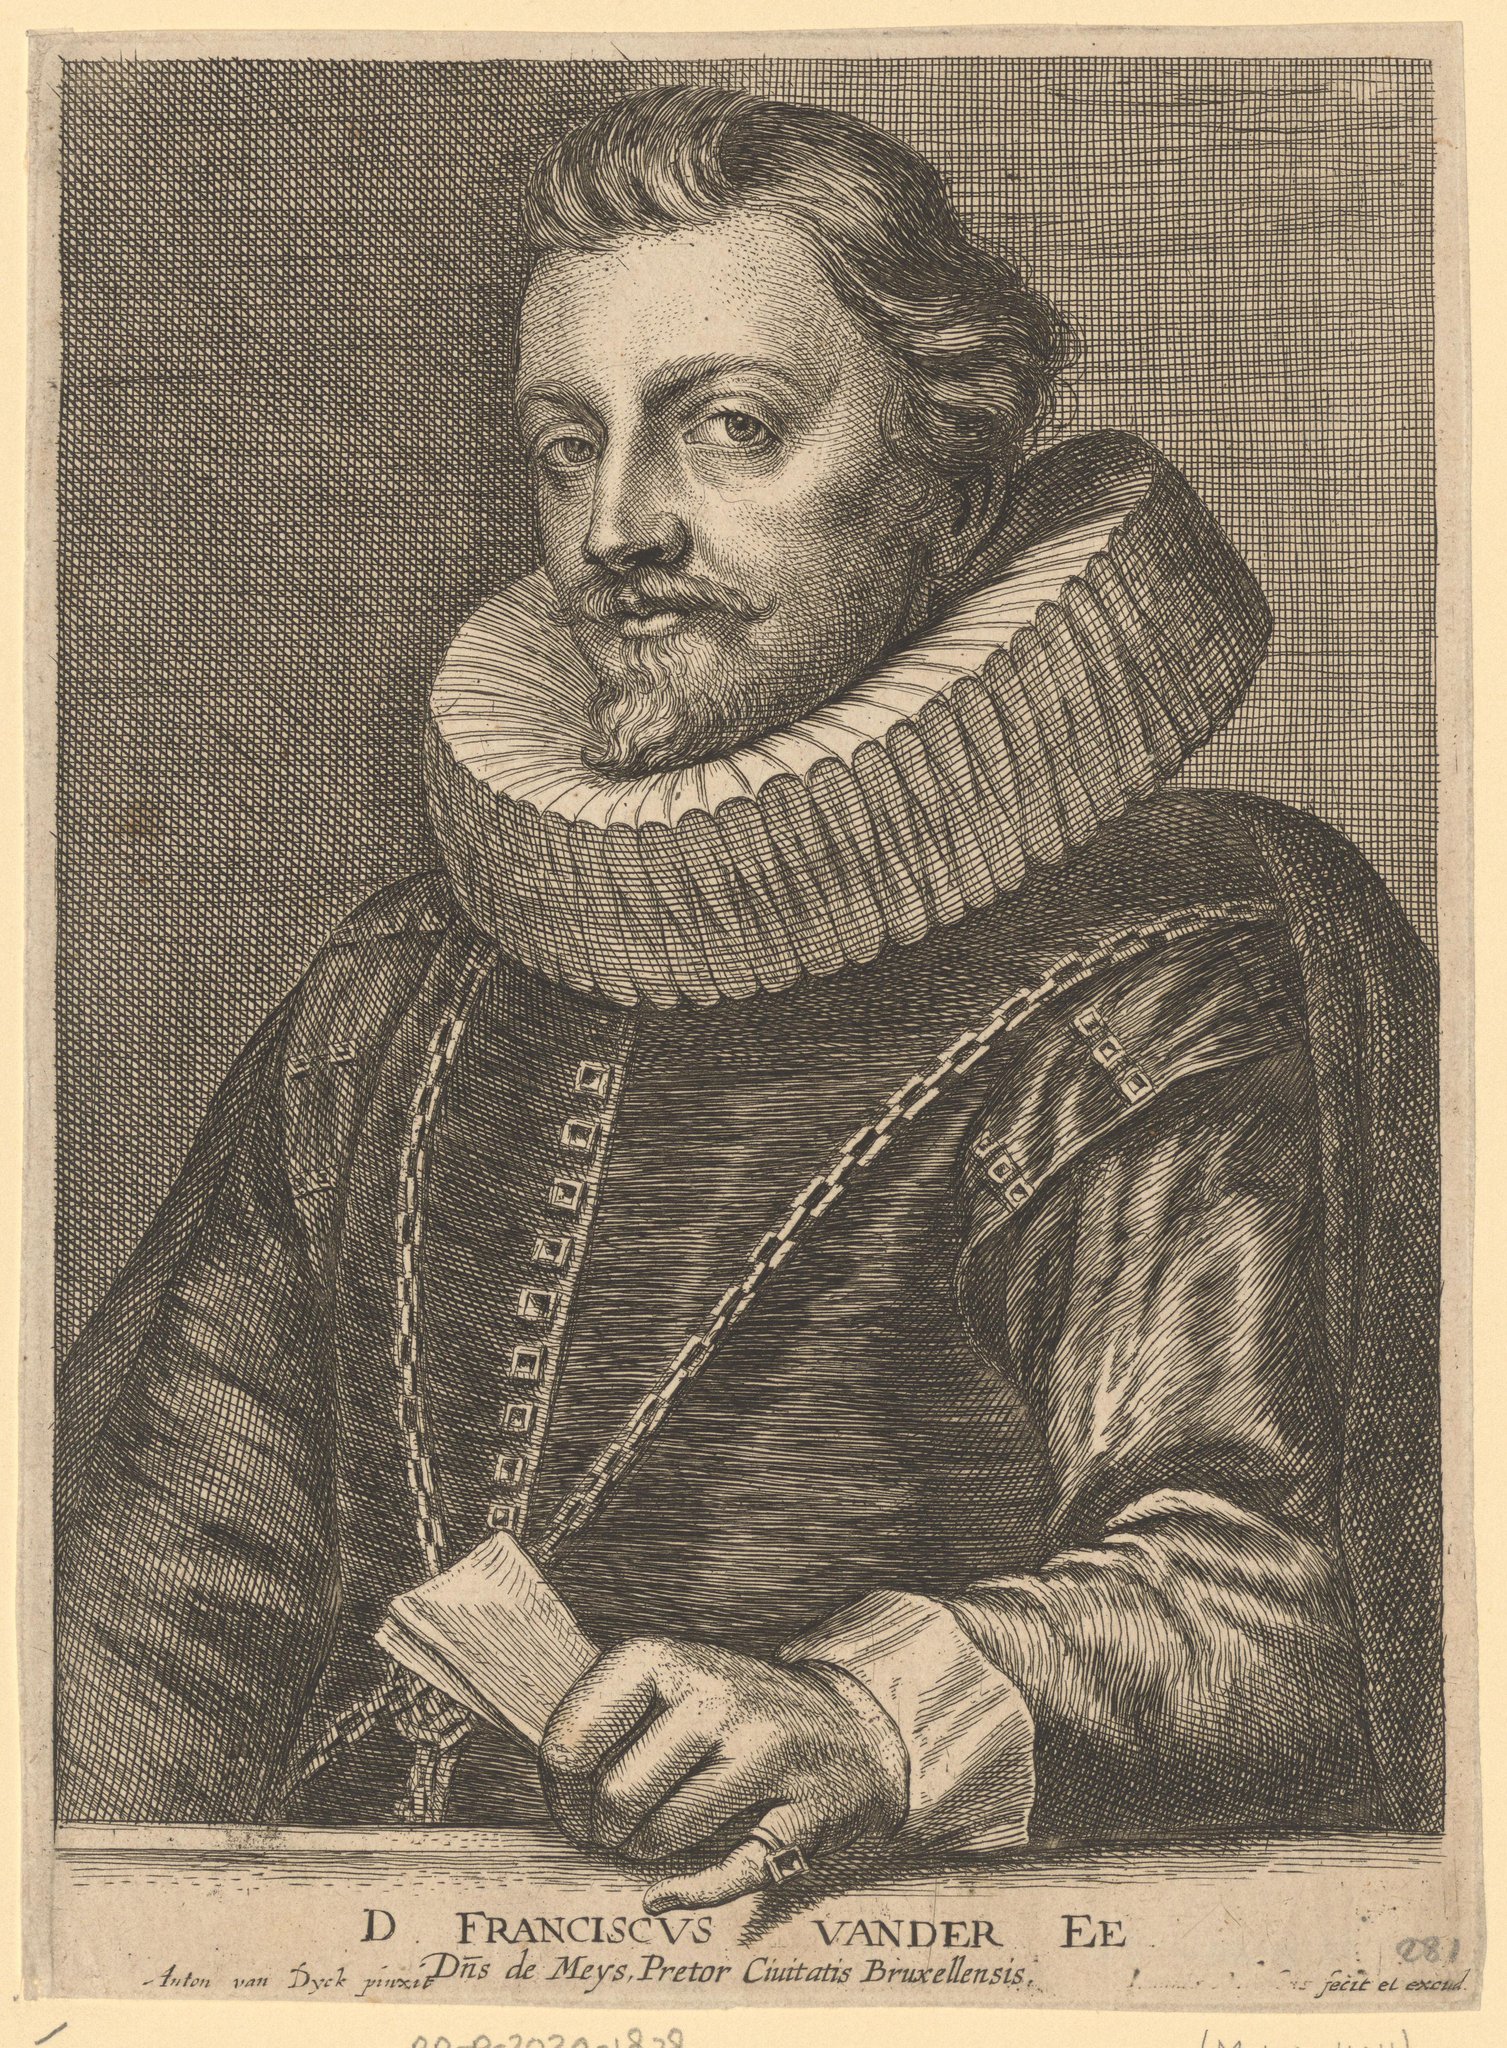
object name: print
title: Portret van Franciscus van der Ee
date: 1640-1670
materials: paper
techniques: engraving, etching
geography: antwerp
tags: françois van der ee, historical persons, bailiff